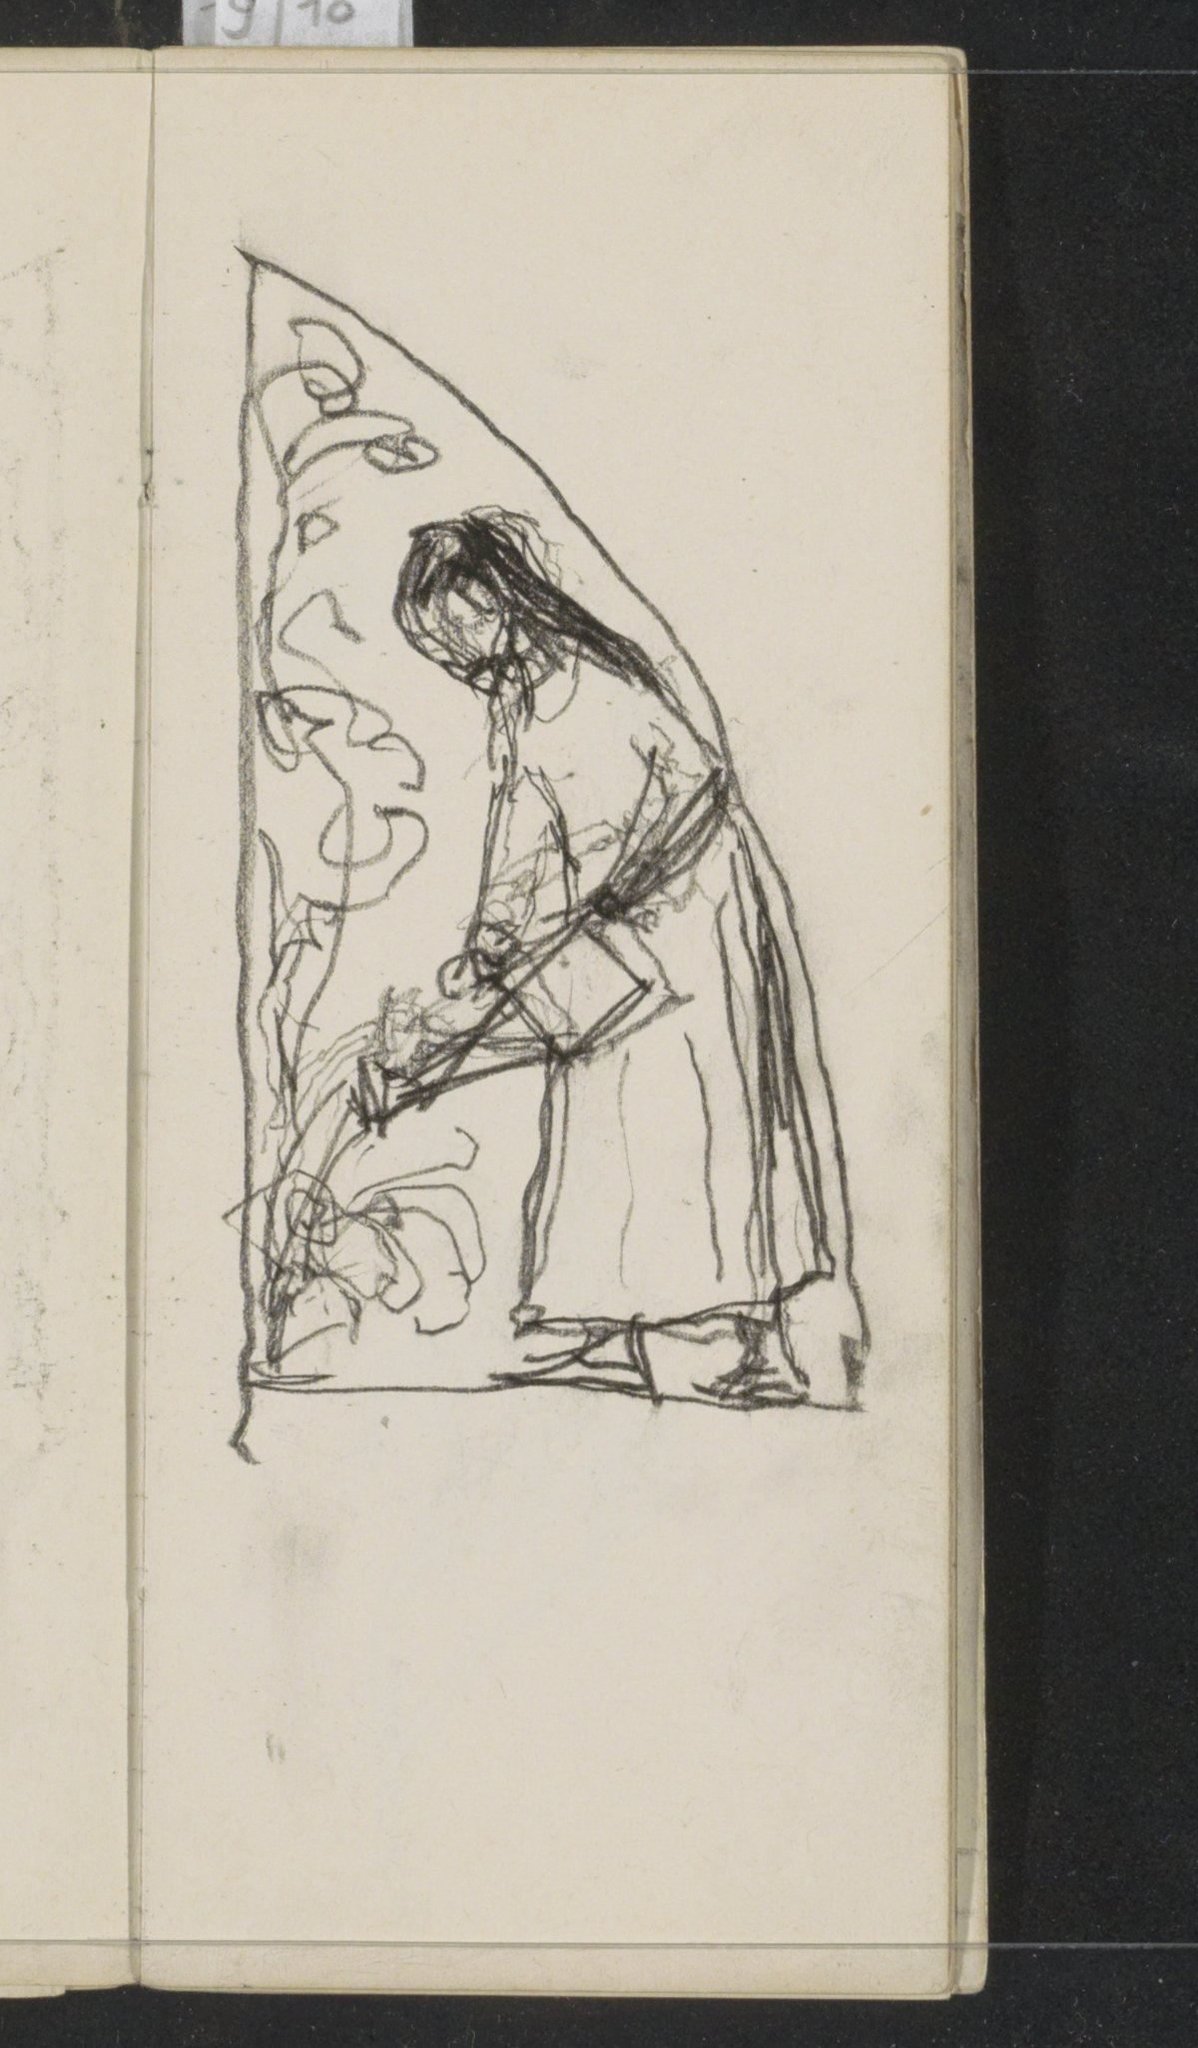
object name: sketchbook leaf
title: Vrouw die een plant water geeft met een gieter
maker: gerrit willem dijsselhof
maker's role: designer, draughtsman, print maker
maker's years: 1866-1924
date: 1876-1924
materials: chalk, paper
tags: plants (in general), adult woman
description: Mogelijk een ontwerp voor een venster. Blad 5 recto uit een schetsboek met 24 bladen.